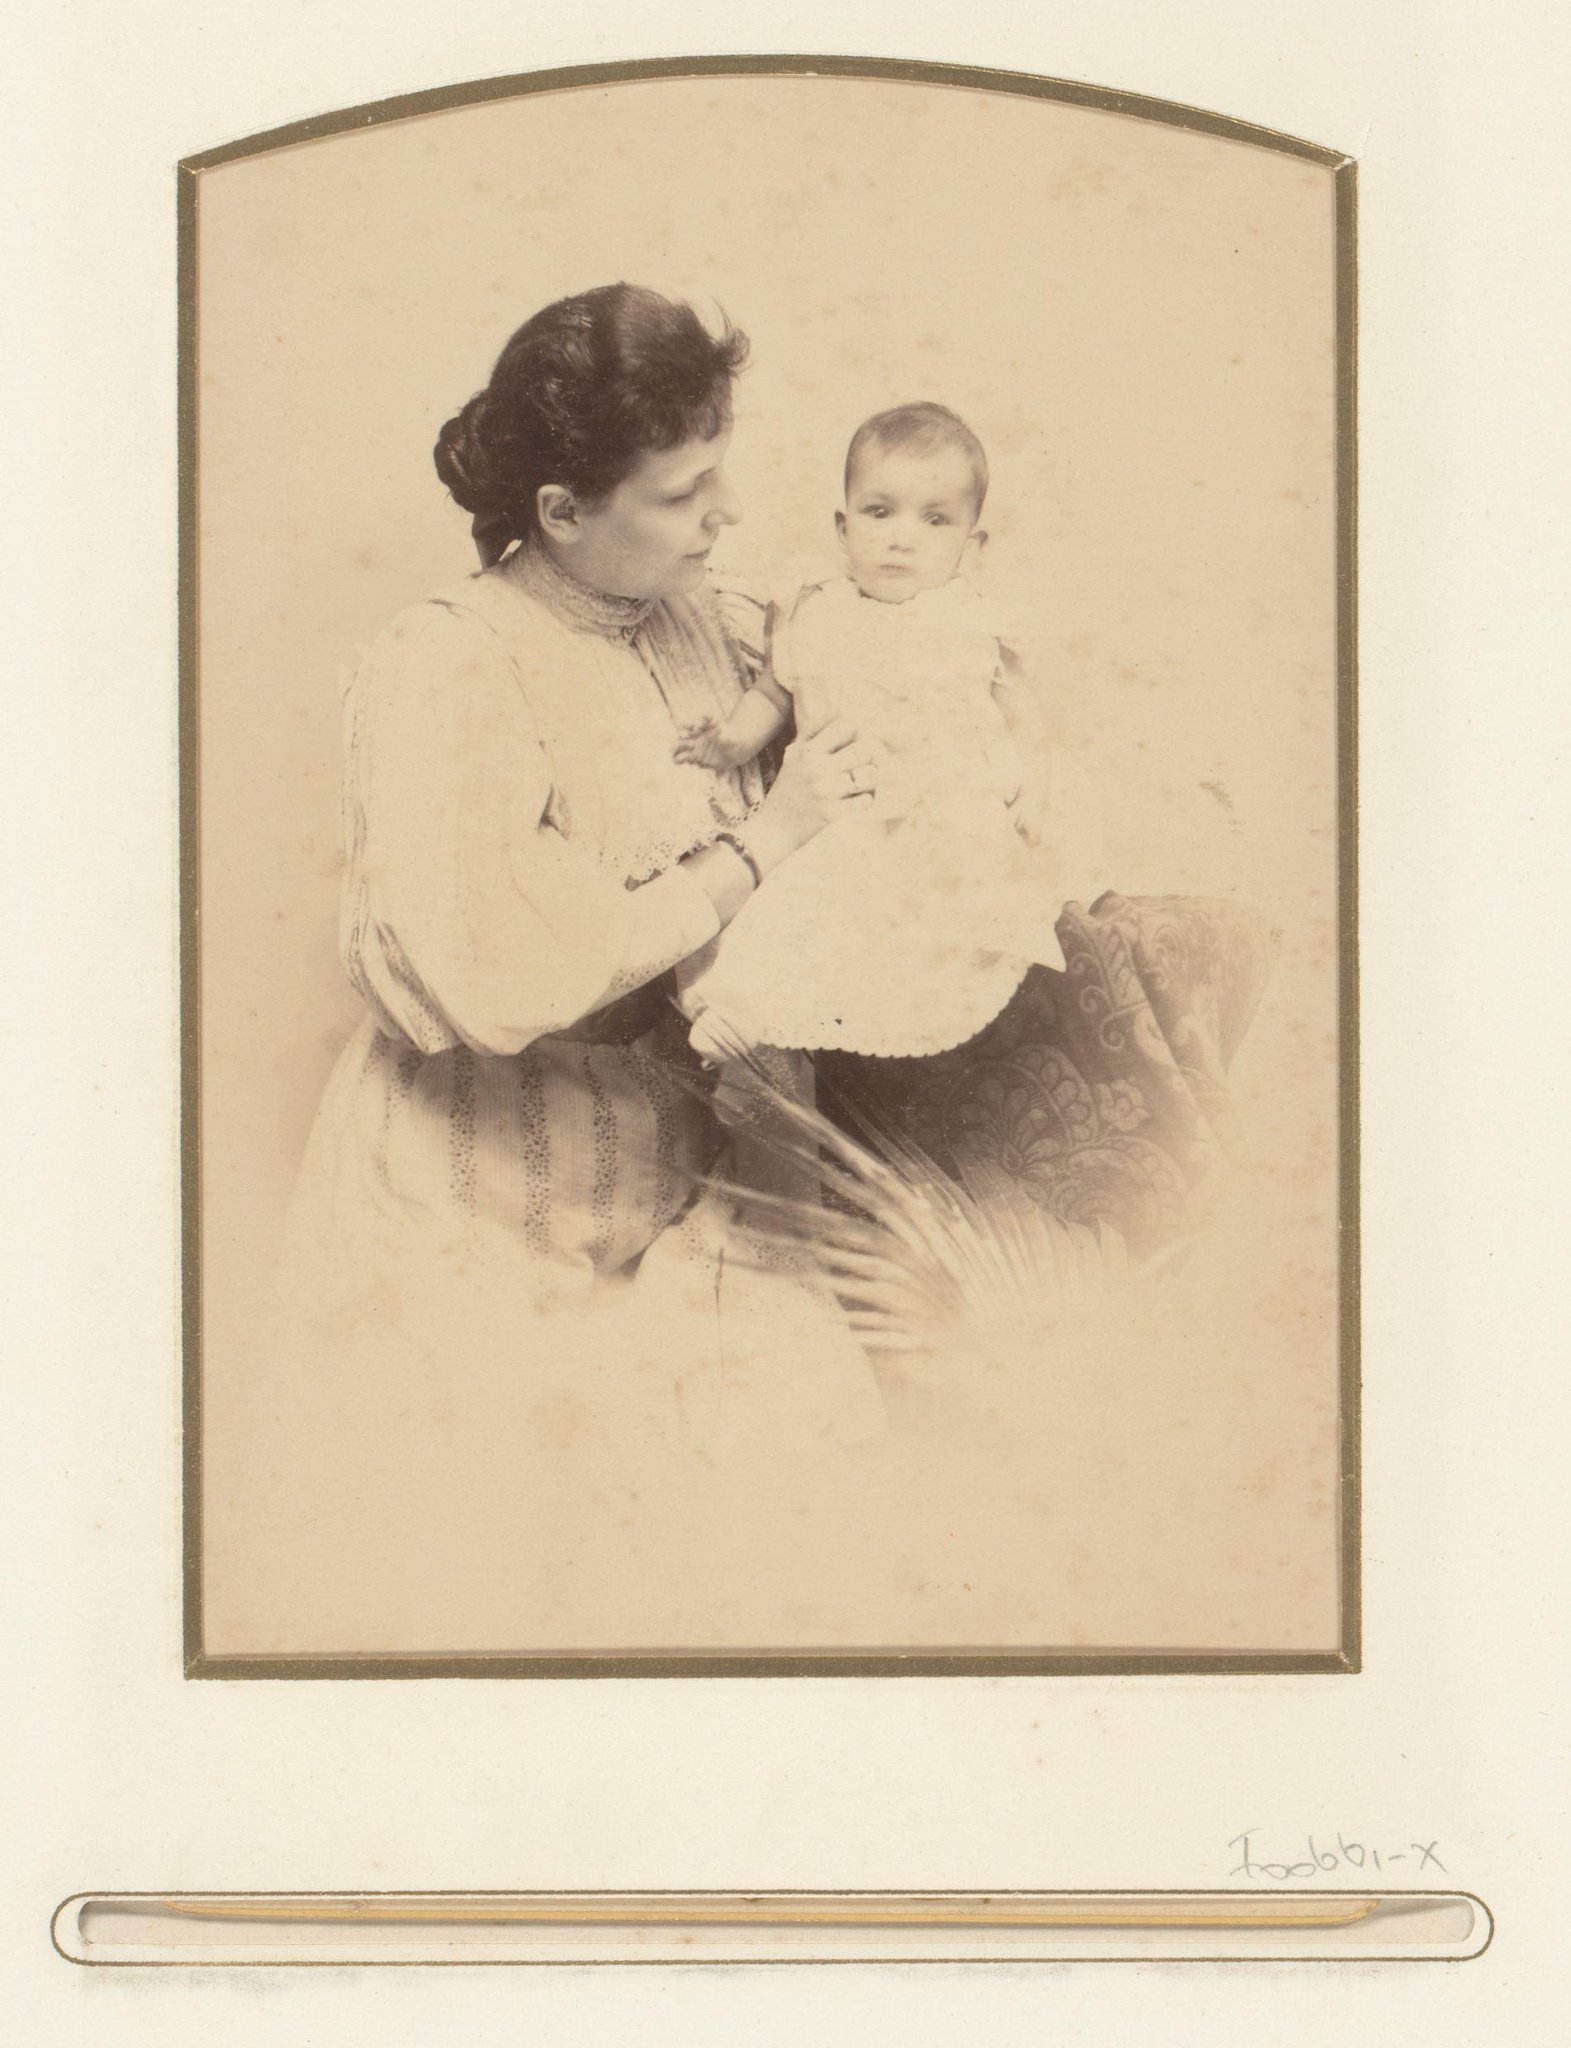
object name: cabinet photograph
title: Portret van een zittende vrouw met een baby op de arm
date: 1867-1900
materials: cardboard, photographic support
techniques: albumen print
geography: singapore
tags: historical persons - bb - woman, infant, baby ~ the ages of man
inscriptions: inscription: ‘Photographers/ By appointment/ to H. M. the King of Siam/ and/ to H.R.H. the Sultan/ of Johore/ G. R. Lambert & Co/ Singapore/ &/ Strait's Settlements.’